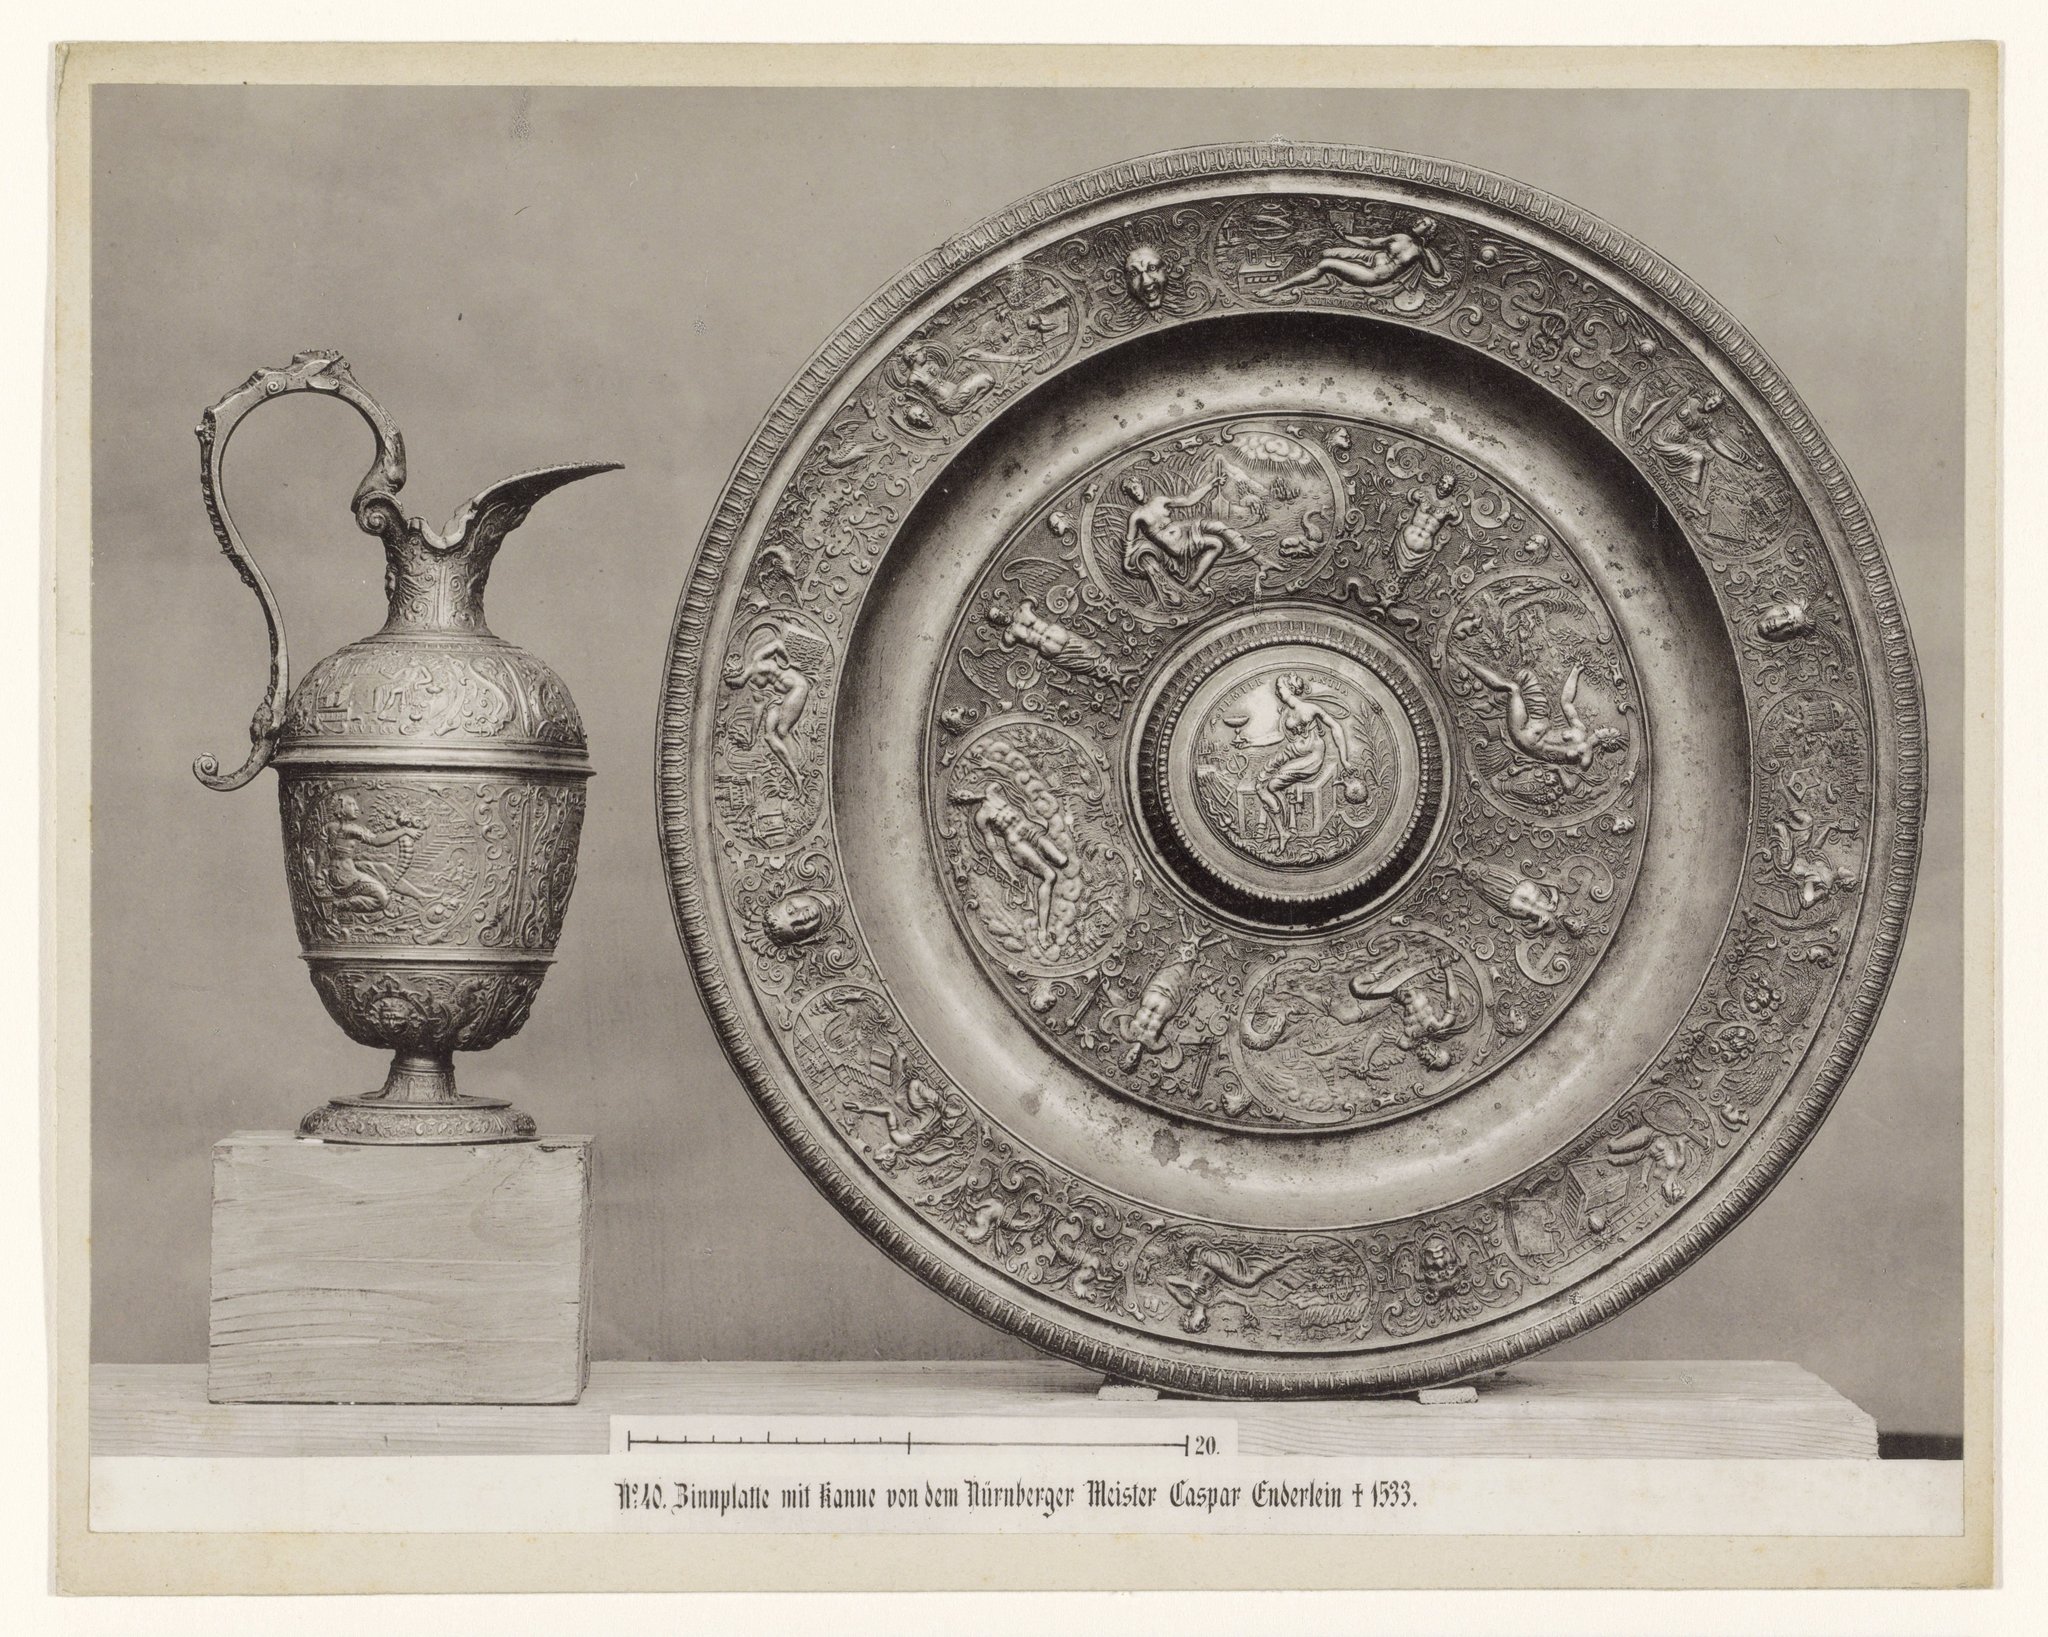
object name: photomechanical print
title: Zinnplatte mit Kanne von dem Nürnberger Meister Caspar Enderlein † 1533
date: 1869-1887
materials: cardboard, paper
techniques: photograph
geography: munich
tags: jar, jug (used as drinking-vessel), dish, plate, saucer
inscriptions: title: ‘No. 40. Zinnplatte mit Kanne von dem Nürnberger Meister Caspar Enderlein † 1533.’